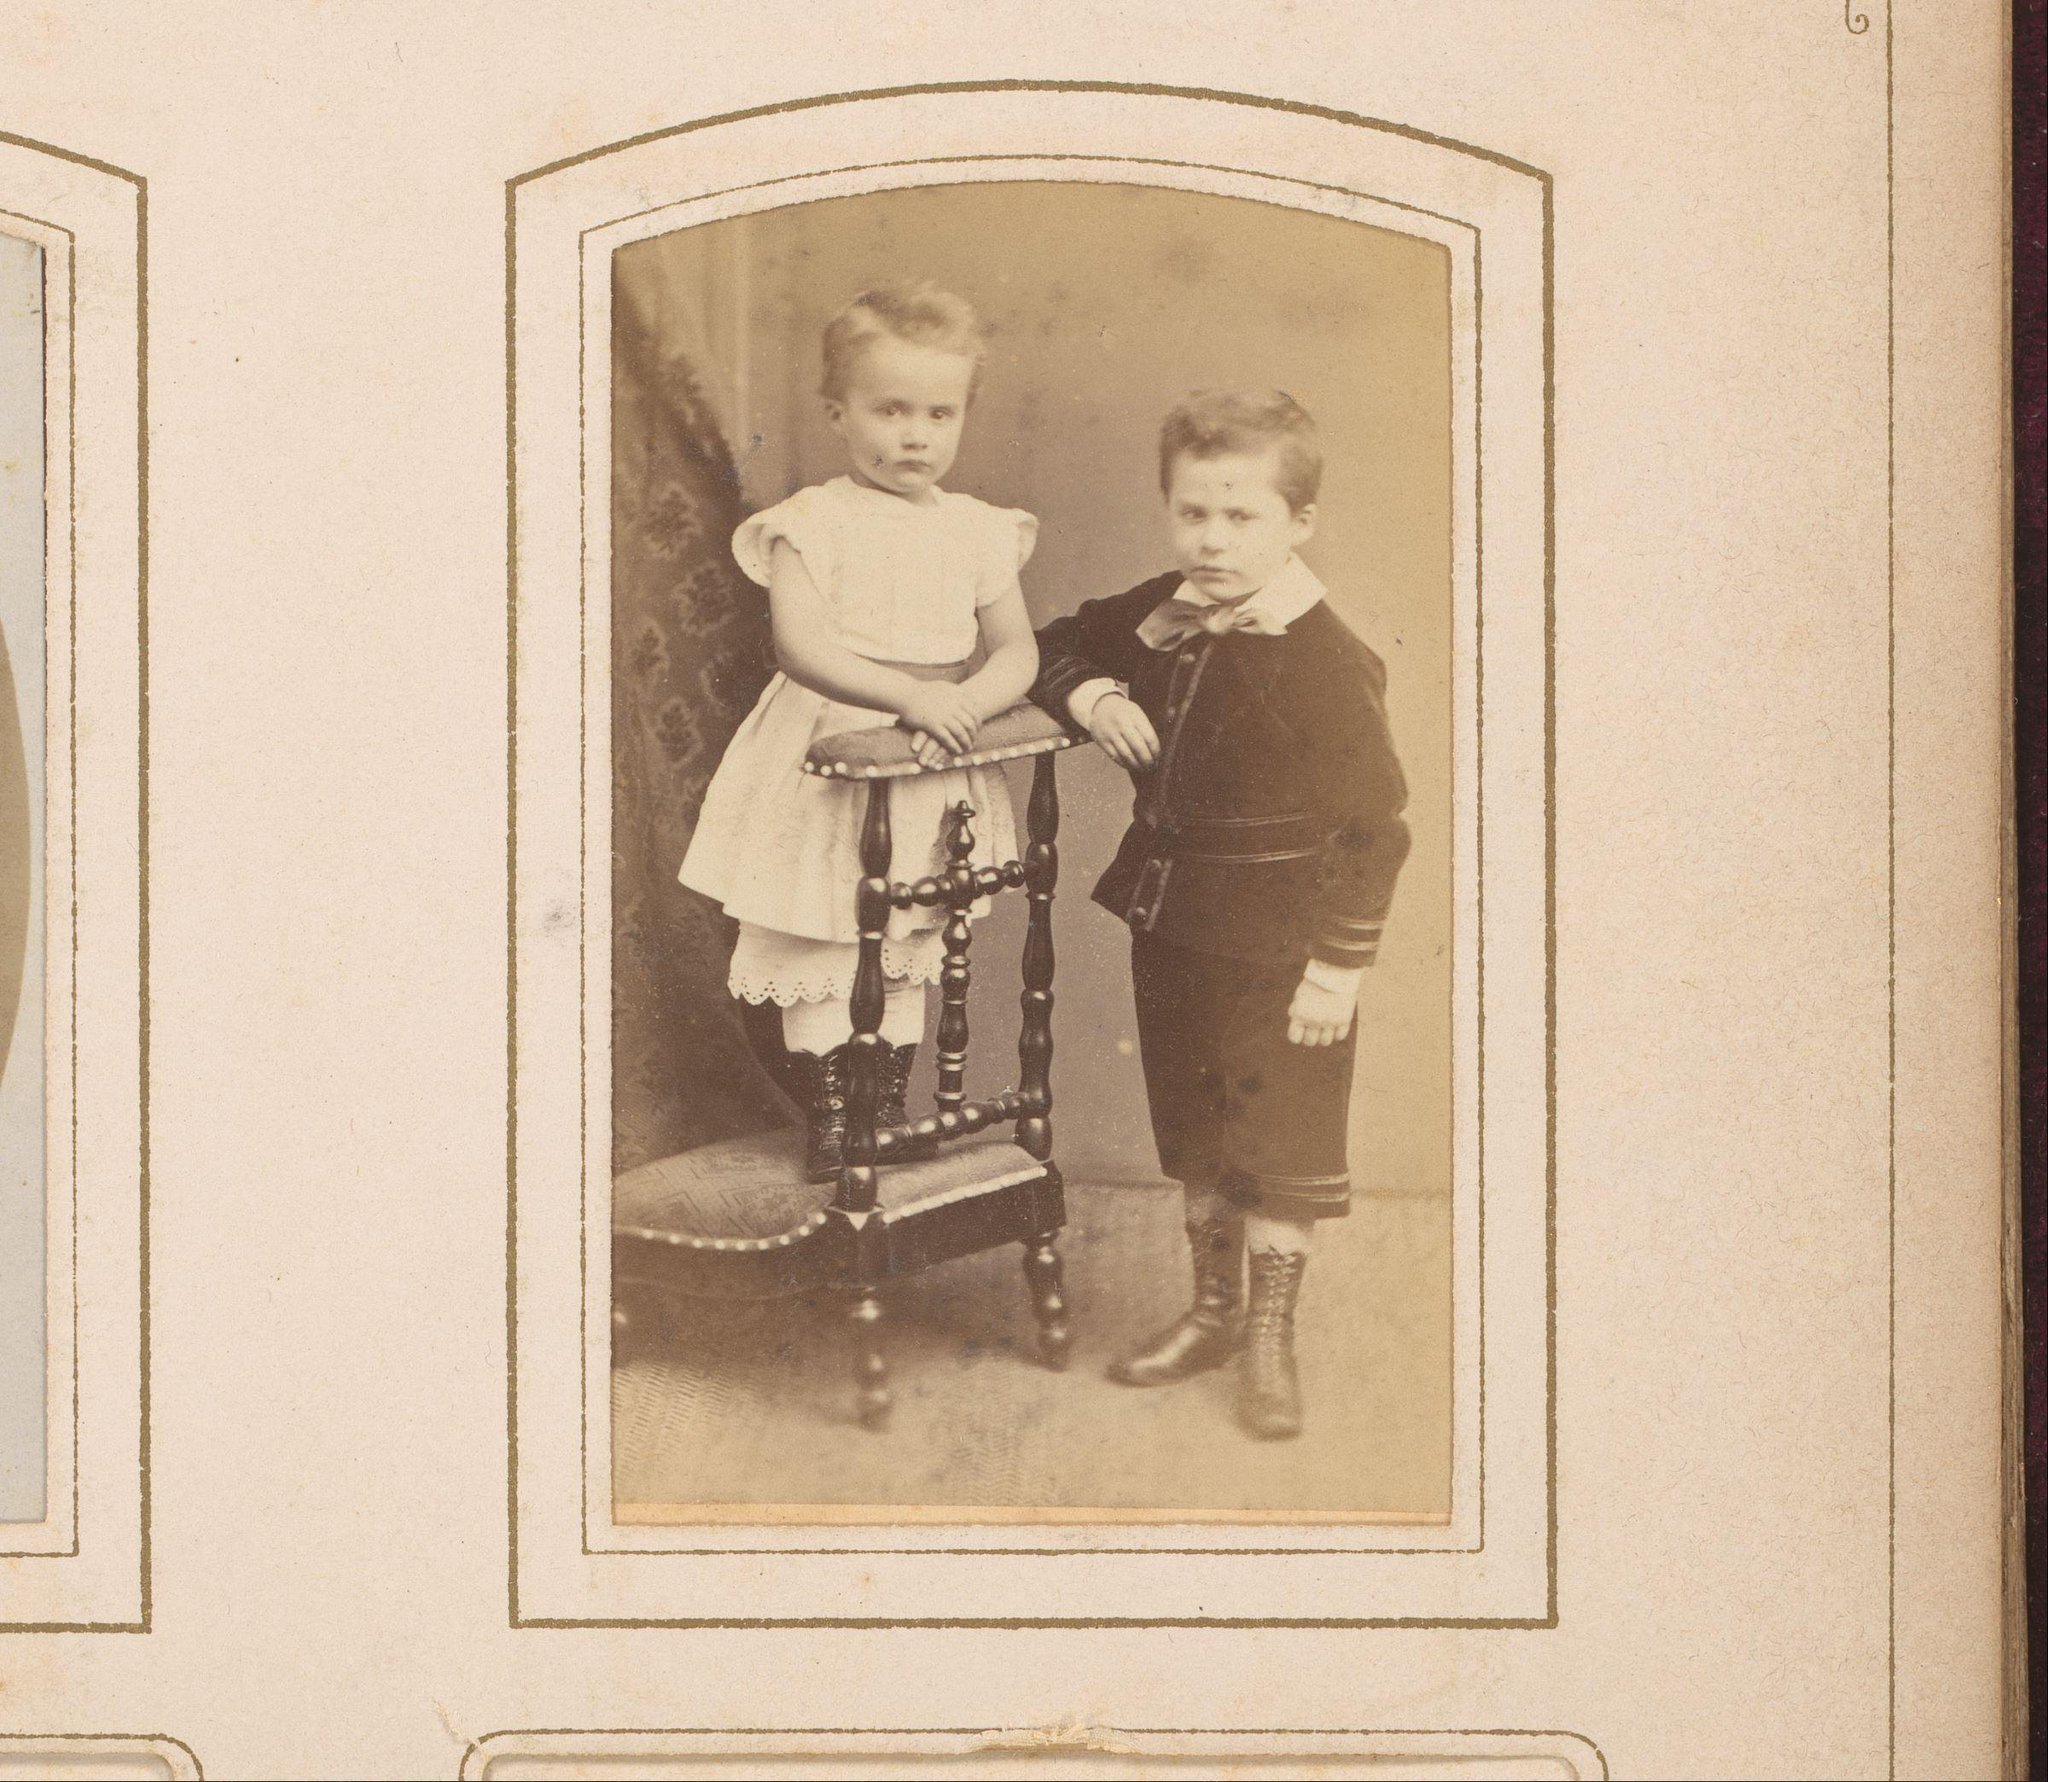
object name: carte de visite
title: Portret van twee kinderen, waarvan één staand op een bidstoel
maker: albert greiner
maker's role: fotograaf, fotostudio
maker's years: 1833-1890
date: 1861-1874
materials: cardboard, photographic support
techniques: albumen print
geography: amsterdam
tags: liturgical furniture, etc., historical persons, child (+ two persons)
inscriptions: inscription: ‘A. Greiner/ Photograf/ NIEUWENDIJK L. 87/ AMSTERDAM’